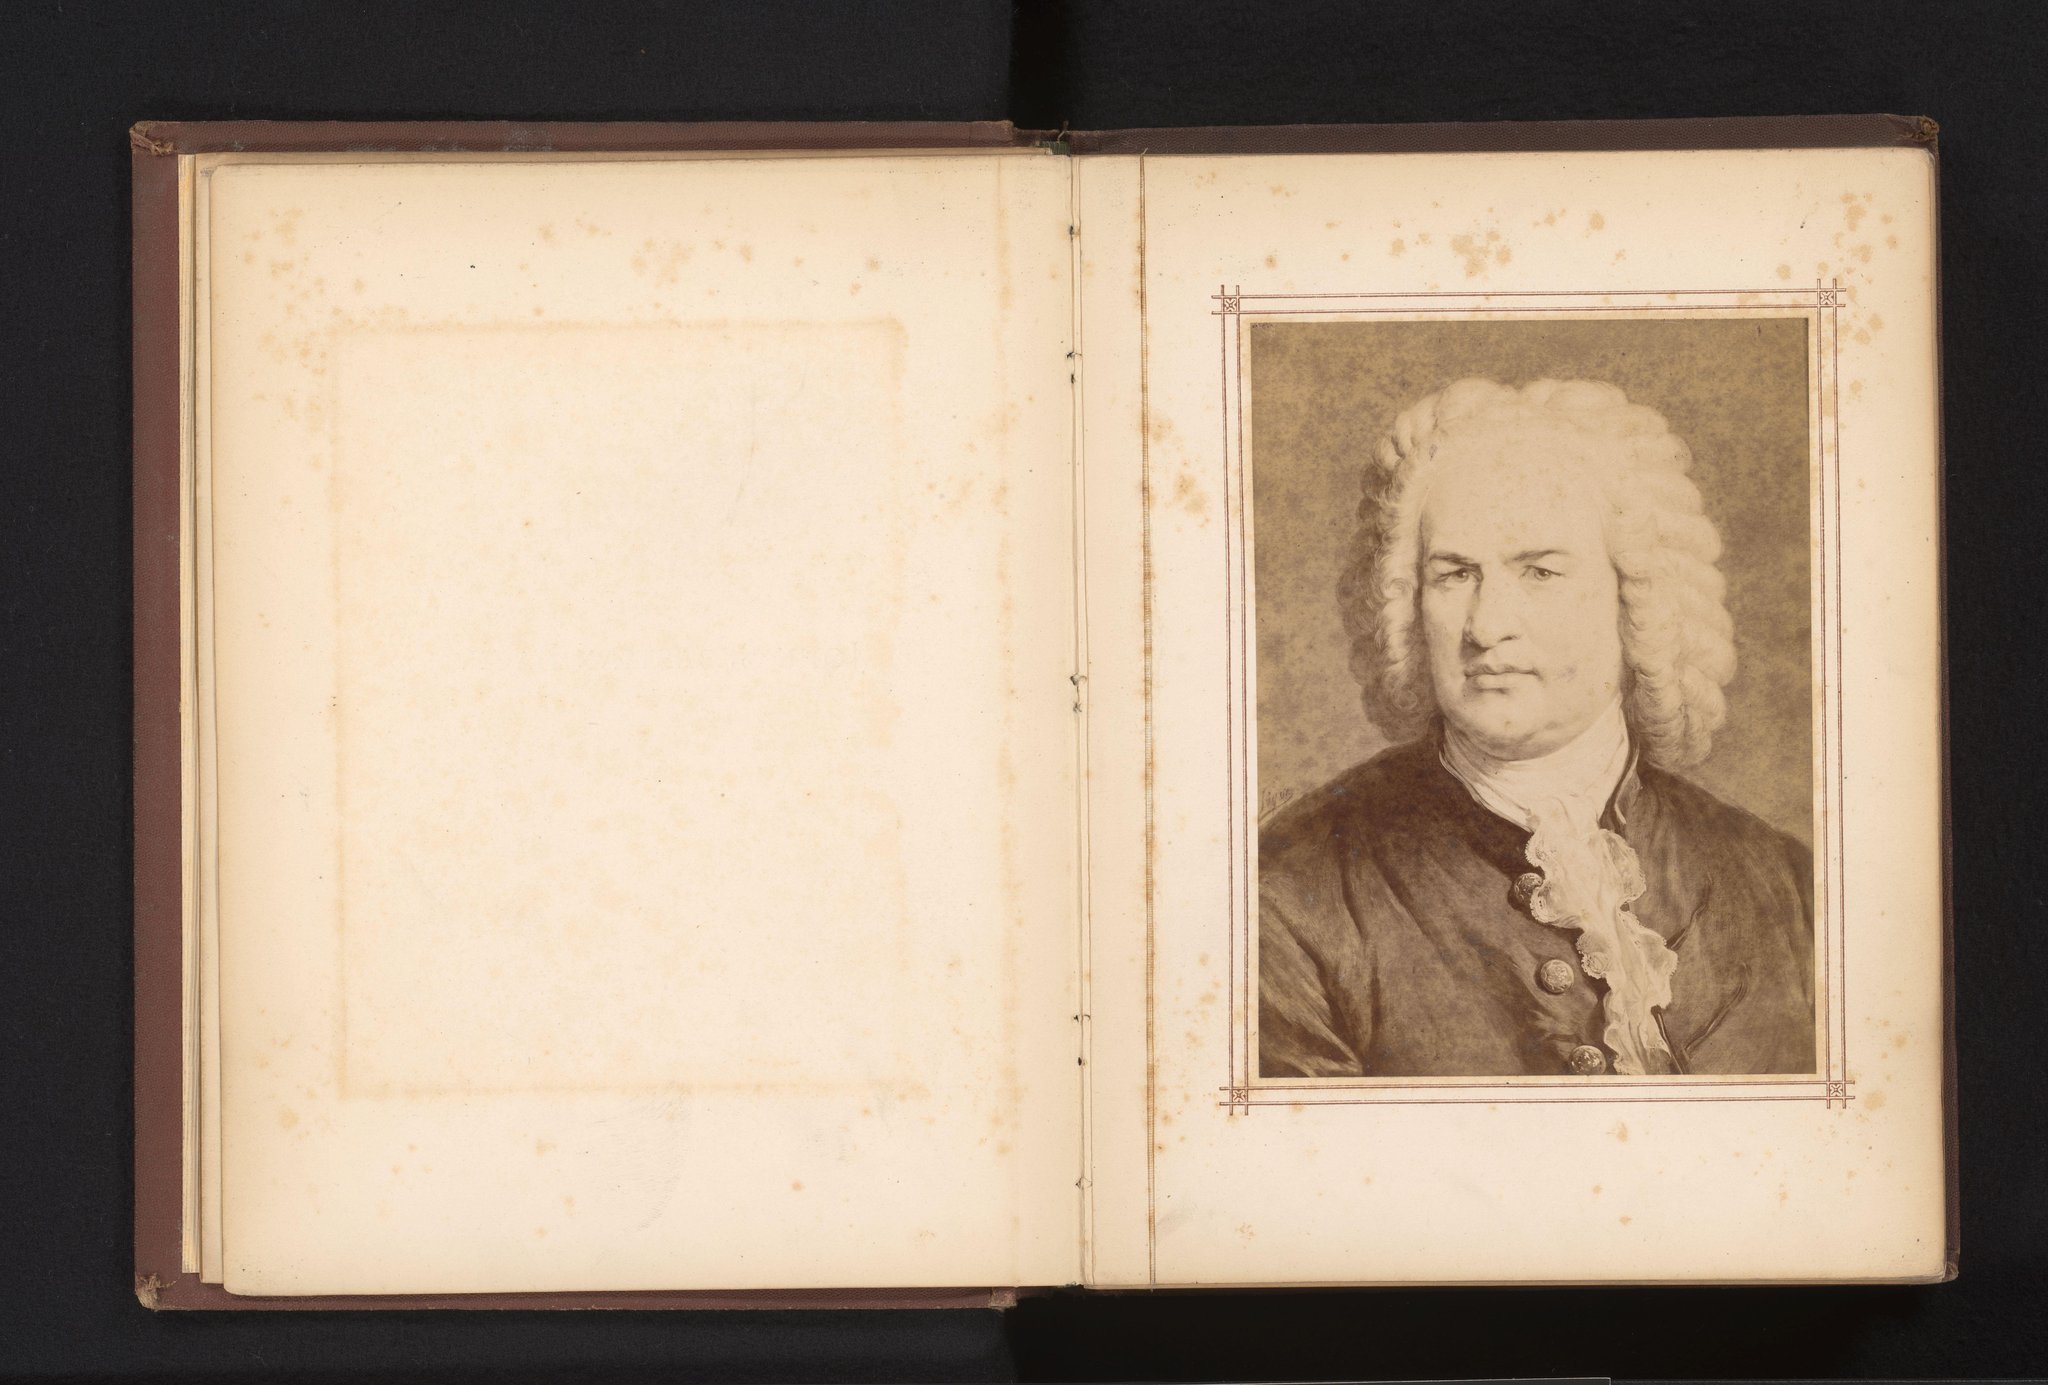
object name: photograph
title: Fotoreproductie van een portret van Johann Sebastian Bach door Carl Jaeger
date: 1865-1875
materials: photographic support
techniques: albumen print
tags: composer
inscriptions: name: ‘C. Jäger’